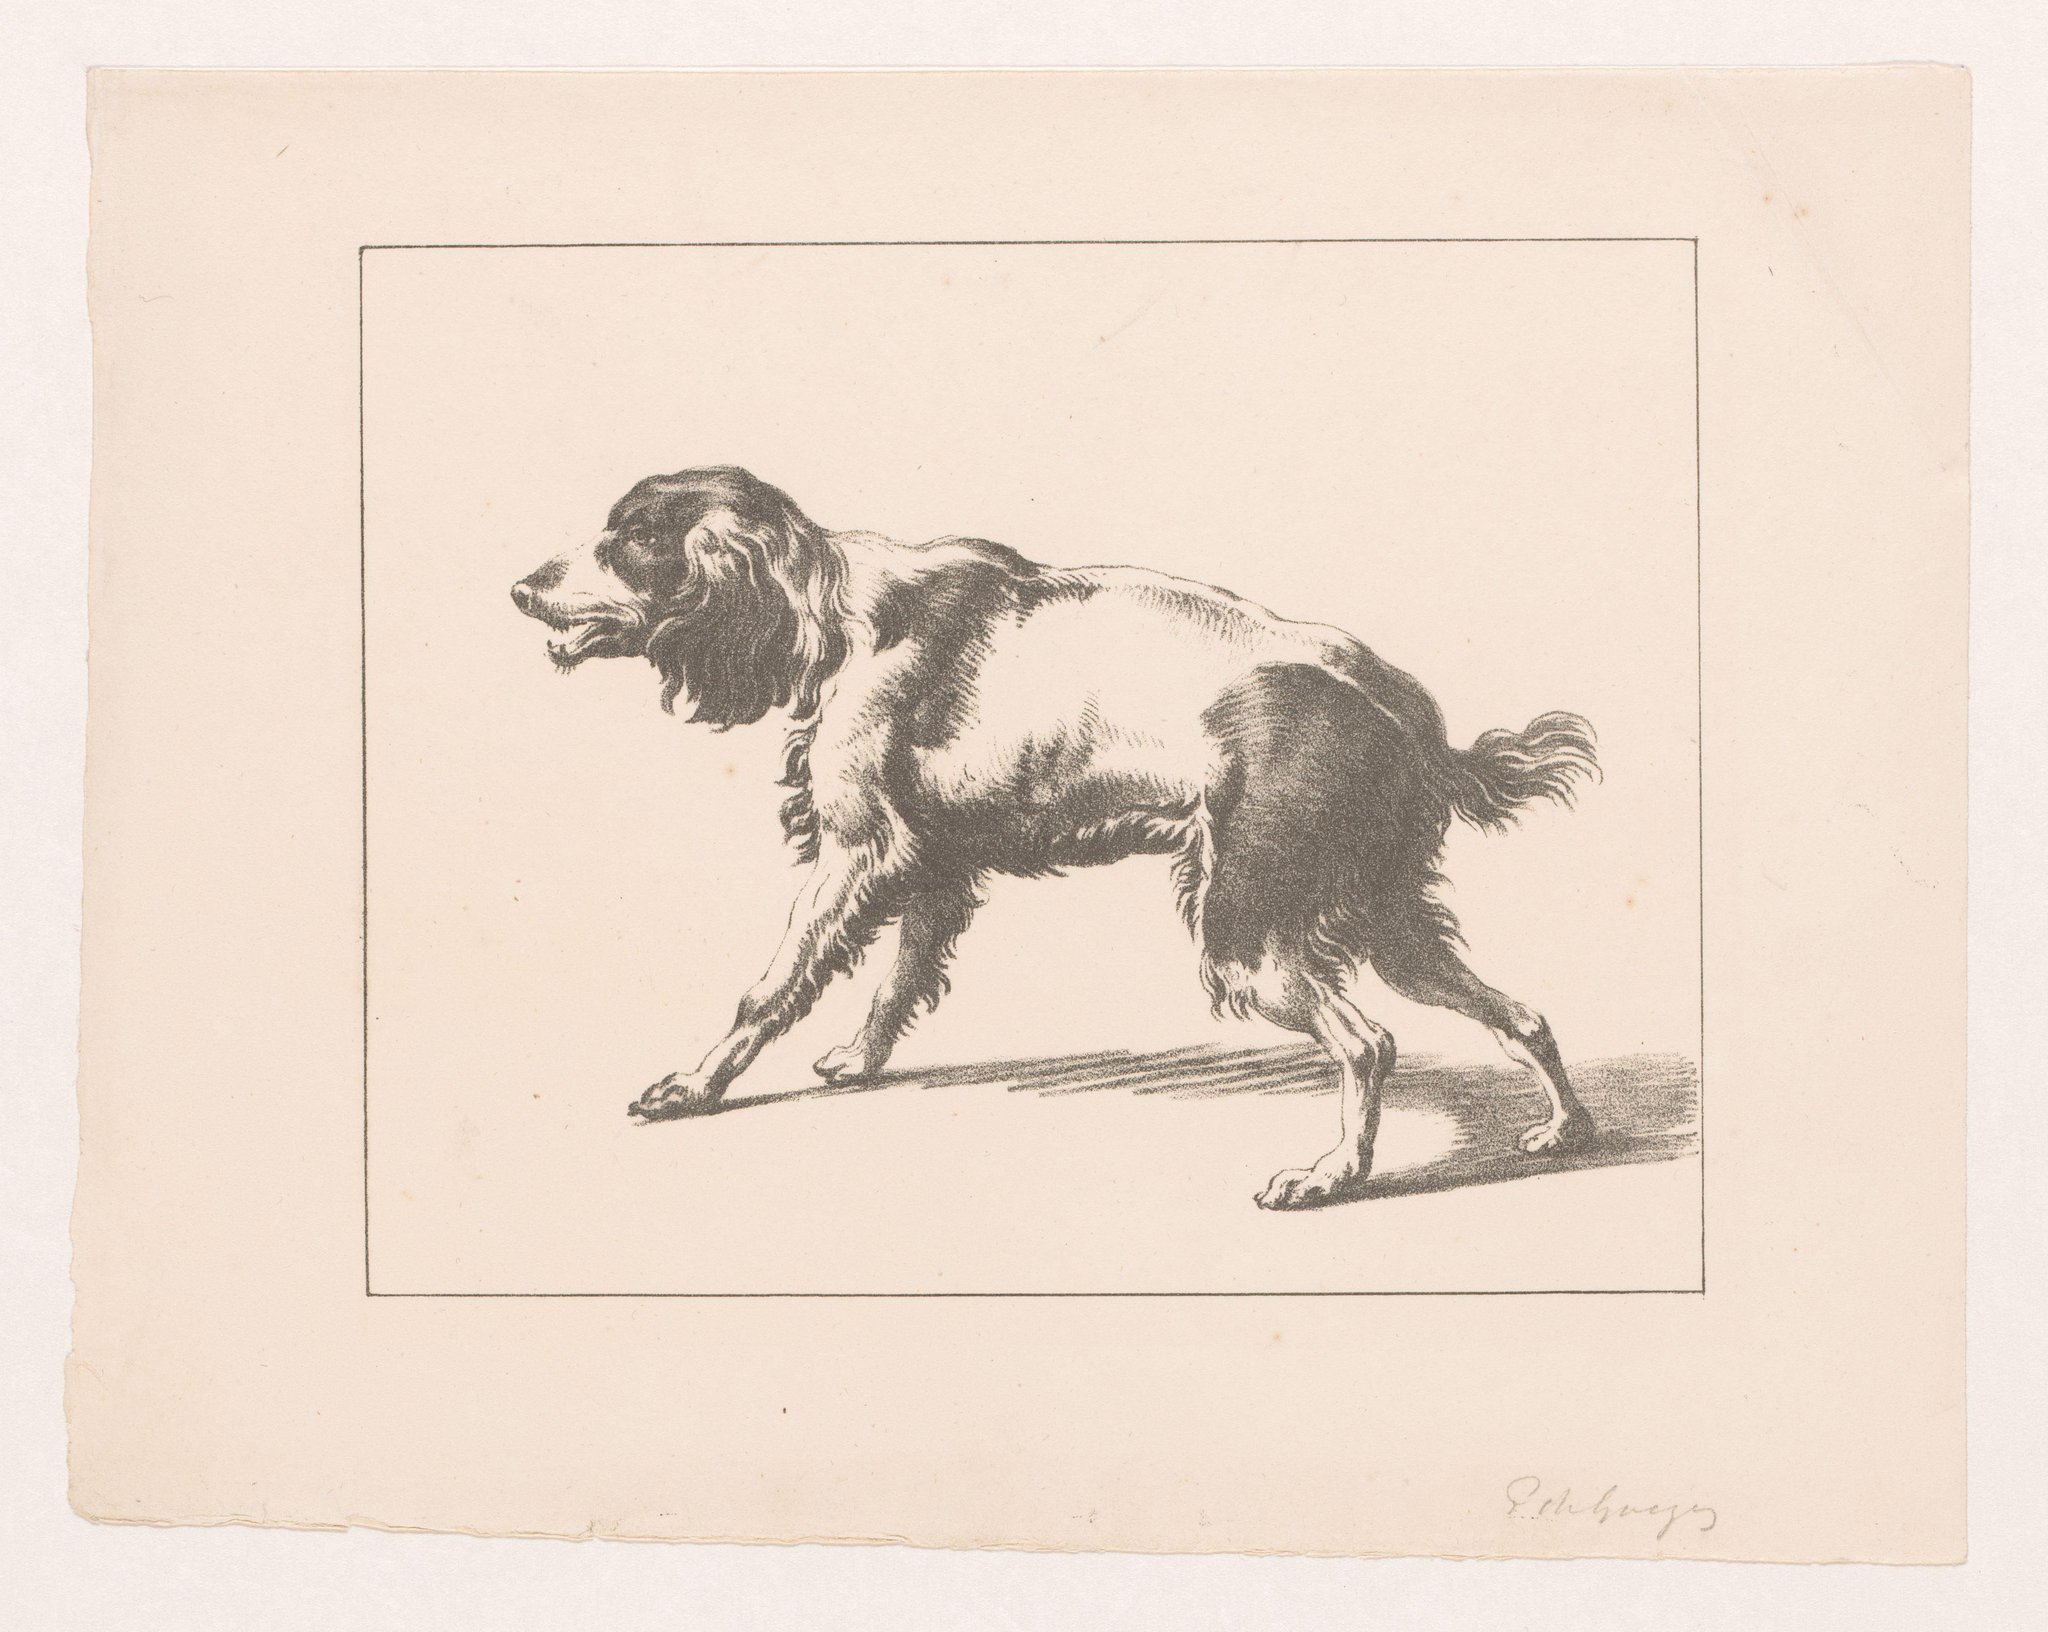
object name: print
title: Staande hond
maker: pieter de goeje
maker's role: draughtsman, print maker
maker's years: 1789-1859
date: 1809-1859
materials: paper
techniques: lithograph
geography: netherlands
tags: dog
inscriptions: collector's mark: Lugt 2228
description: De hond is gevlekt en heeft zijn bek opengesperd.